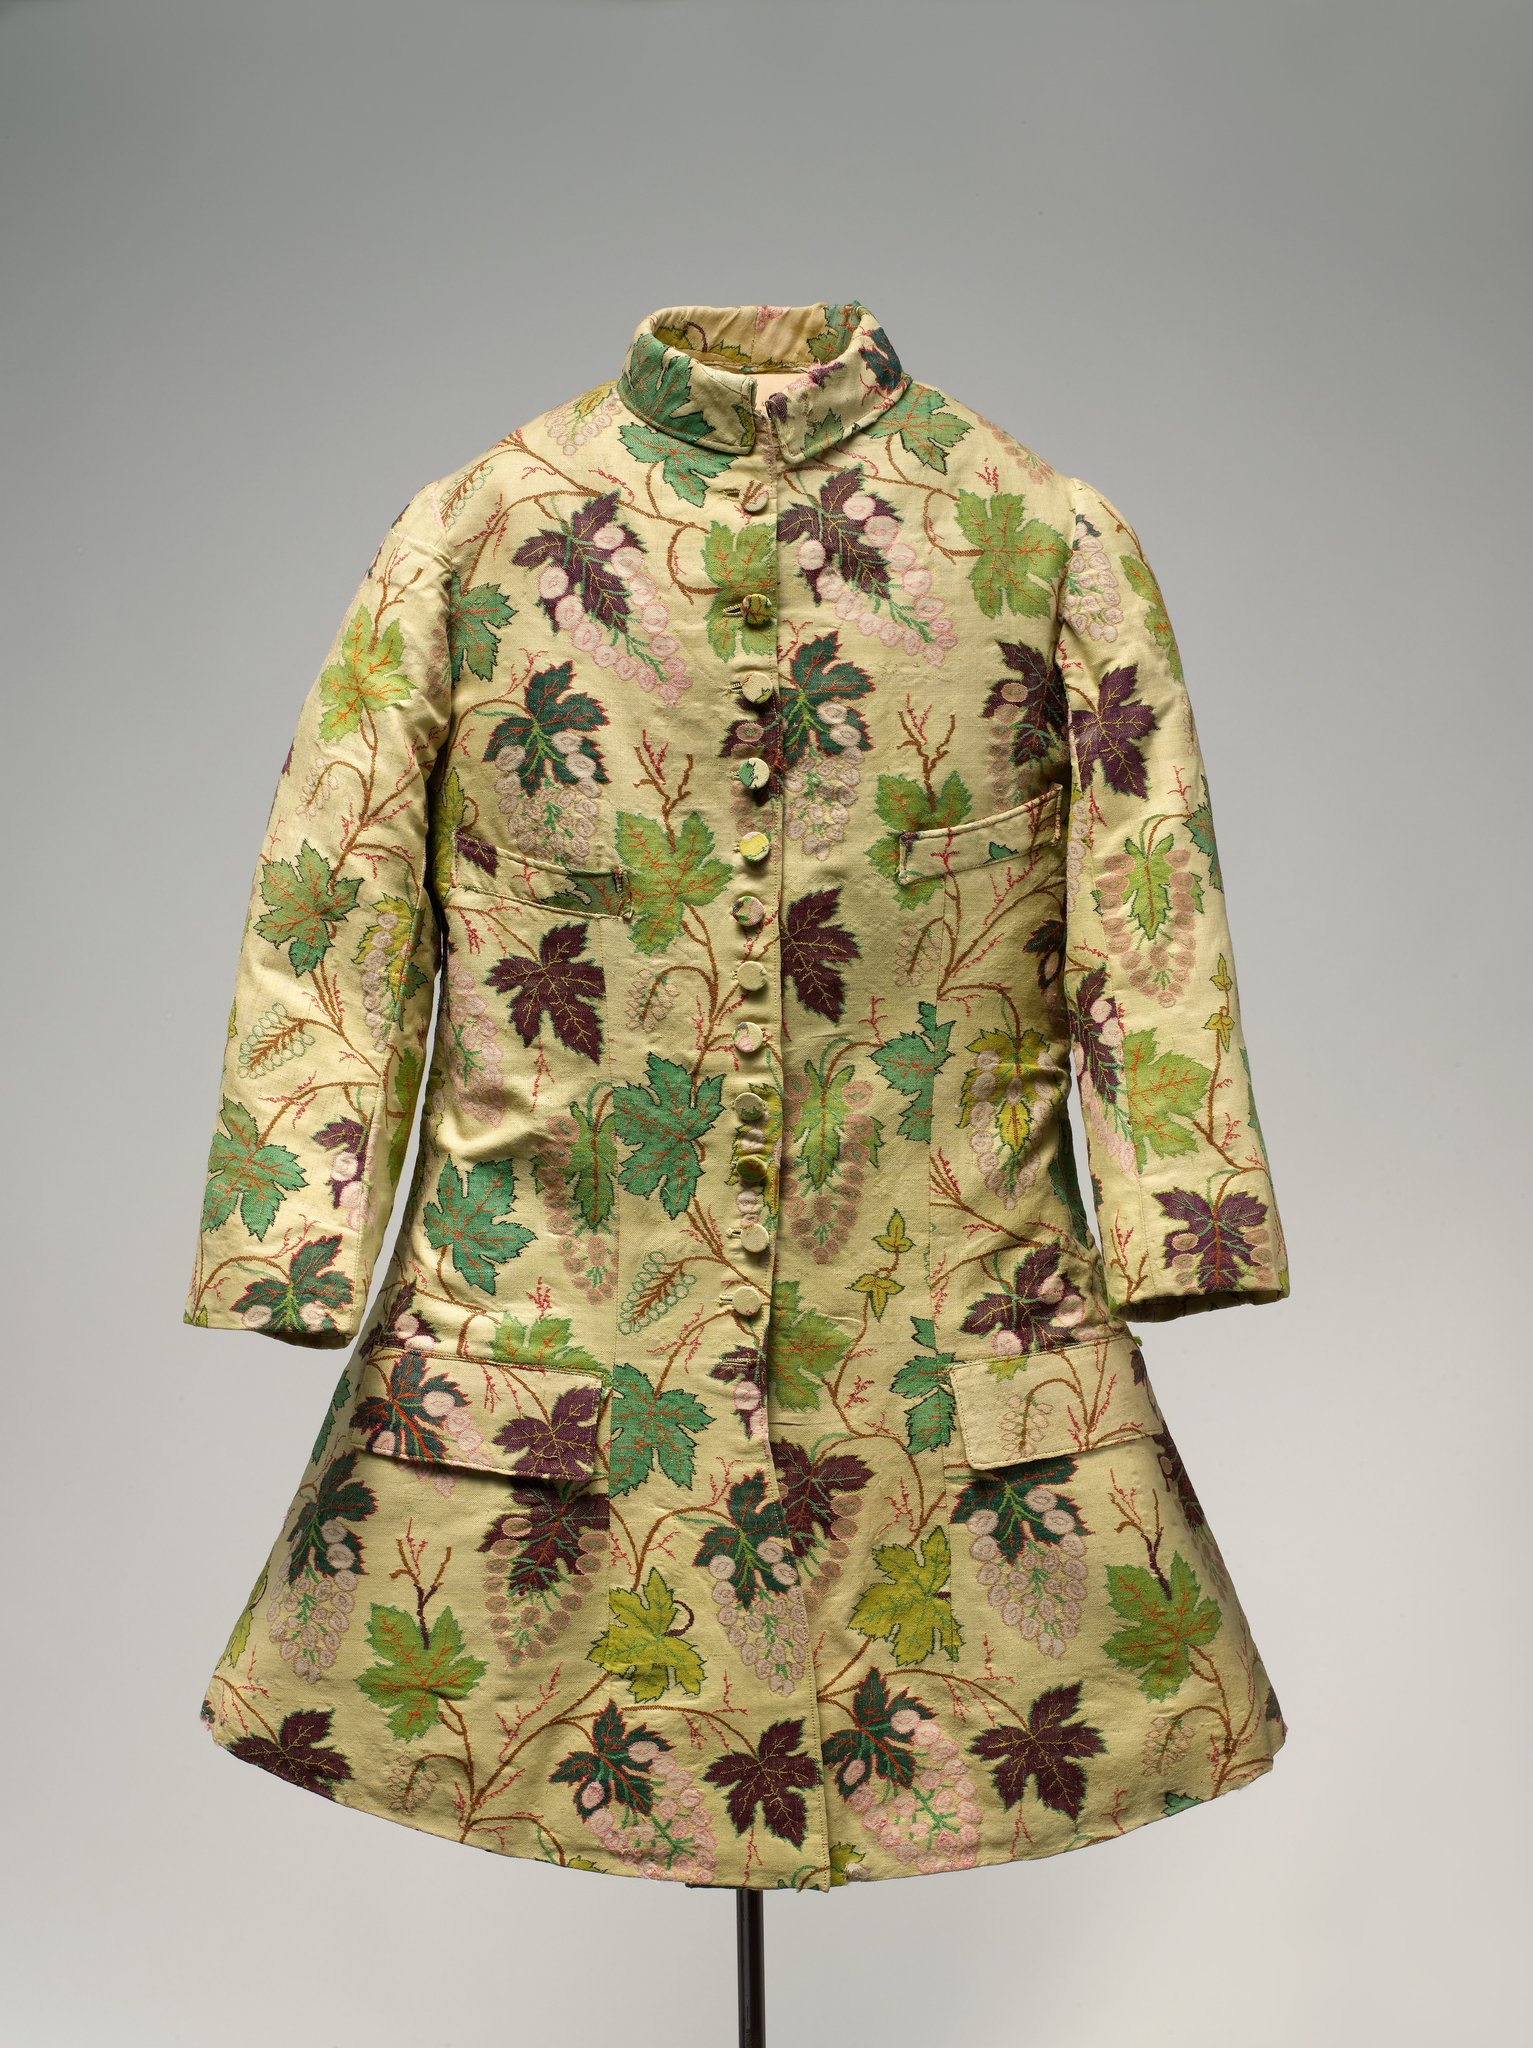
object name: coat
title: Child's Coat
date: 1867-1900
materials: wool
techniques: interlocking, weave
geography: india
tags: leaves